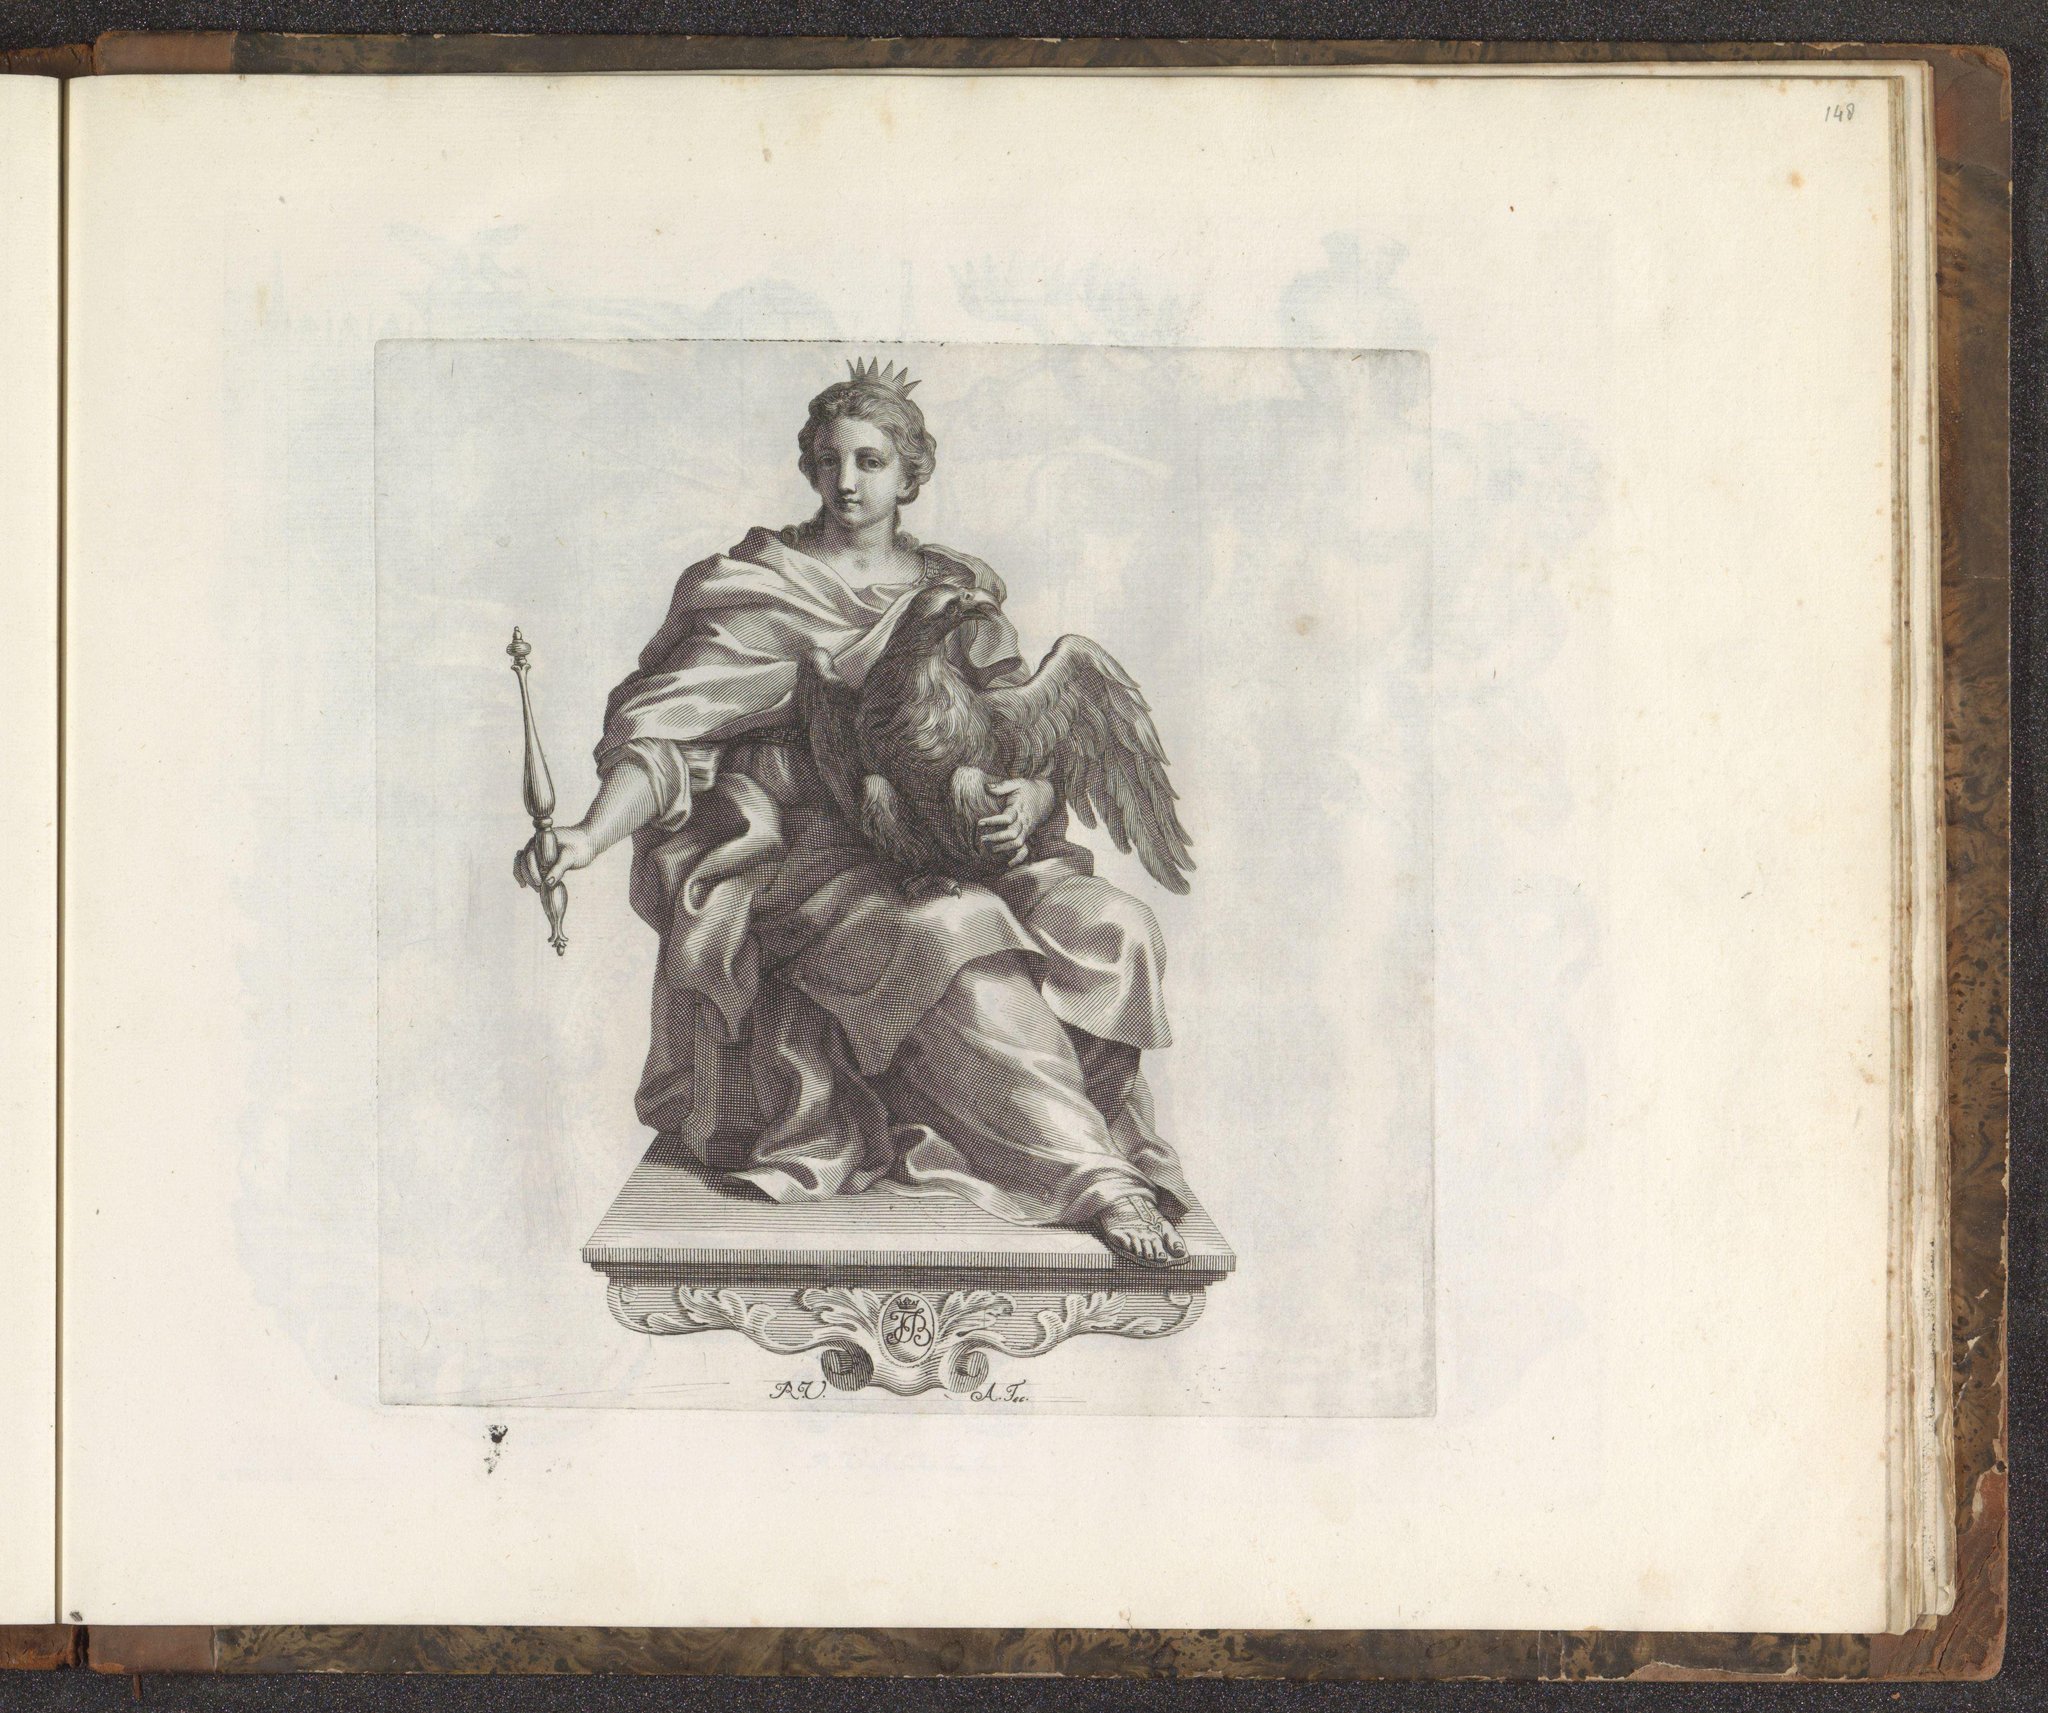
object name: album leaf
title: Personificatie van de Koninklijke Souvereiniteit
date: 1673-1743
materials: paper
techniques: engraving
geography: rome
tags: predatory birds: eagle, regality, majesty; 'maestà regia', 'regalità' (ripa)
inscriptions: collector's mark: Lugt 2228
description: Een console met de vrouwelijke personificatie van de Koninklijke Souvereiniteit: een zittende vrouw met in haar rechterhand een scepter en op haar schoot voor haar linker borst een adelaar. De prent maakt deel uit van een album.